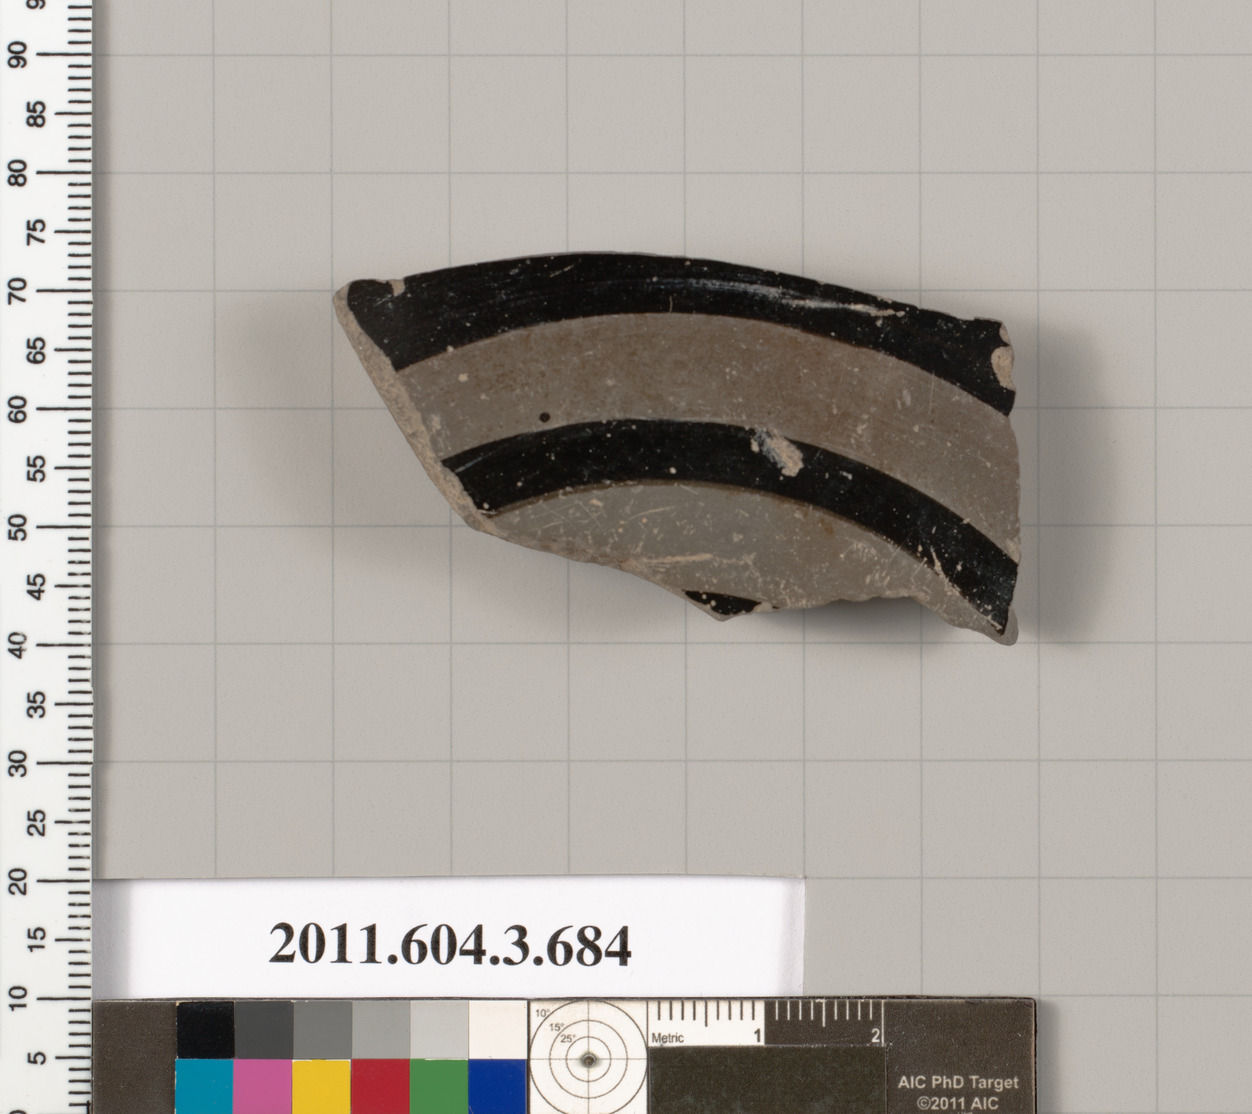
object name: dinos fragment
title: Terracotta fragment of a dinos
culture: greek, attic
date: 510-500 BCE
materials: terracotta